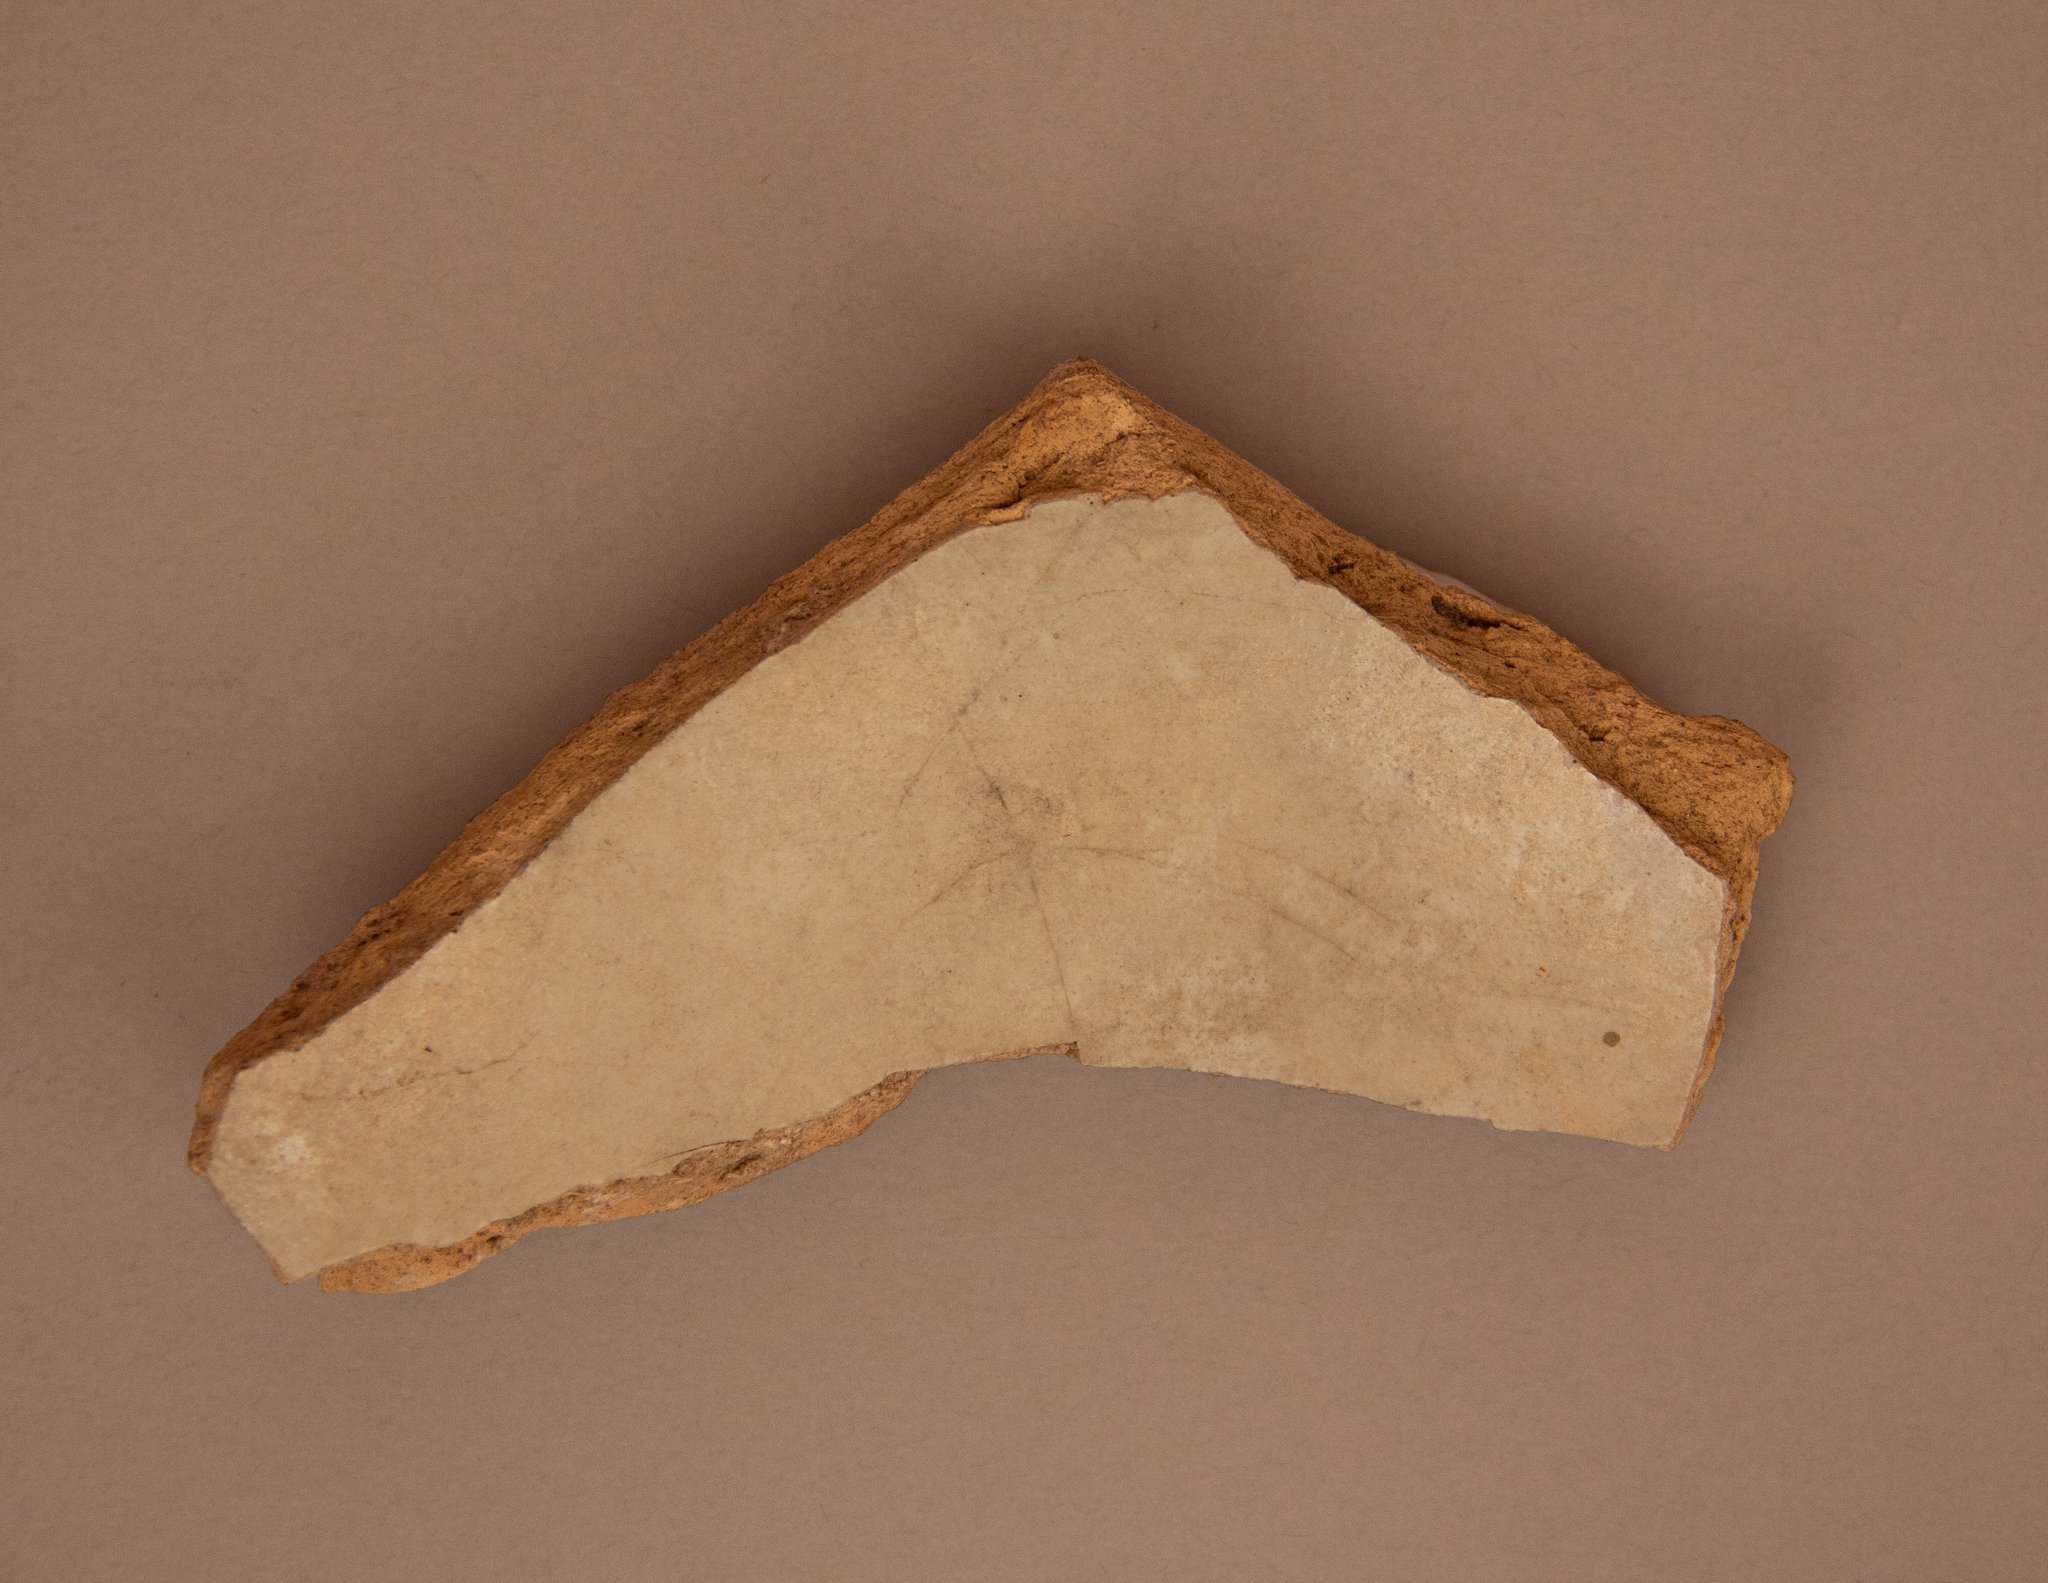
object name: fragment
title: Fragments of Ceramics with Opacified Glaze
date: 801-900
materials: earthenware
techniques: glazing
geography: iraq